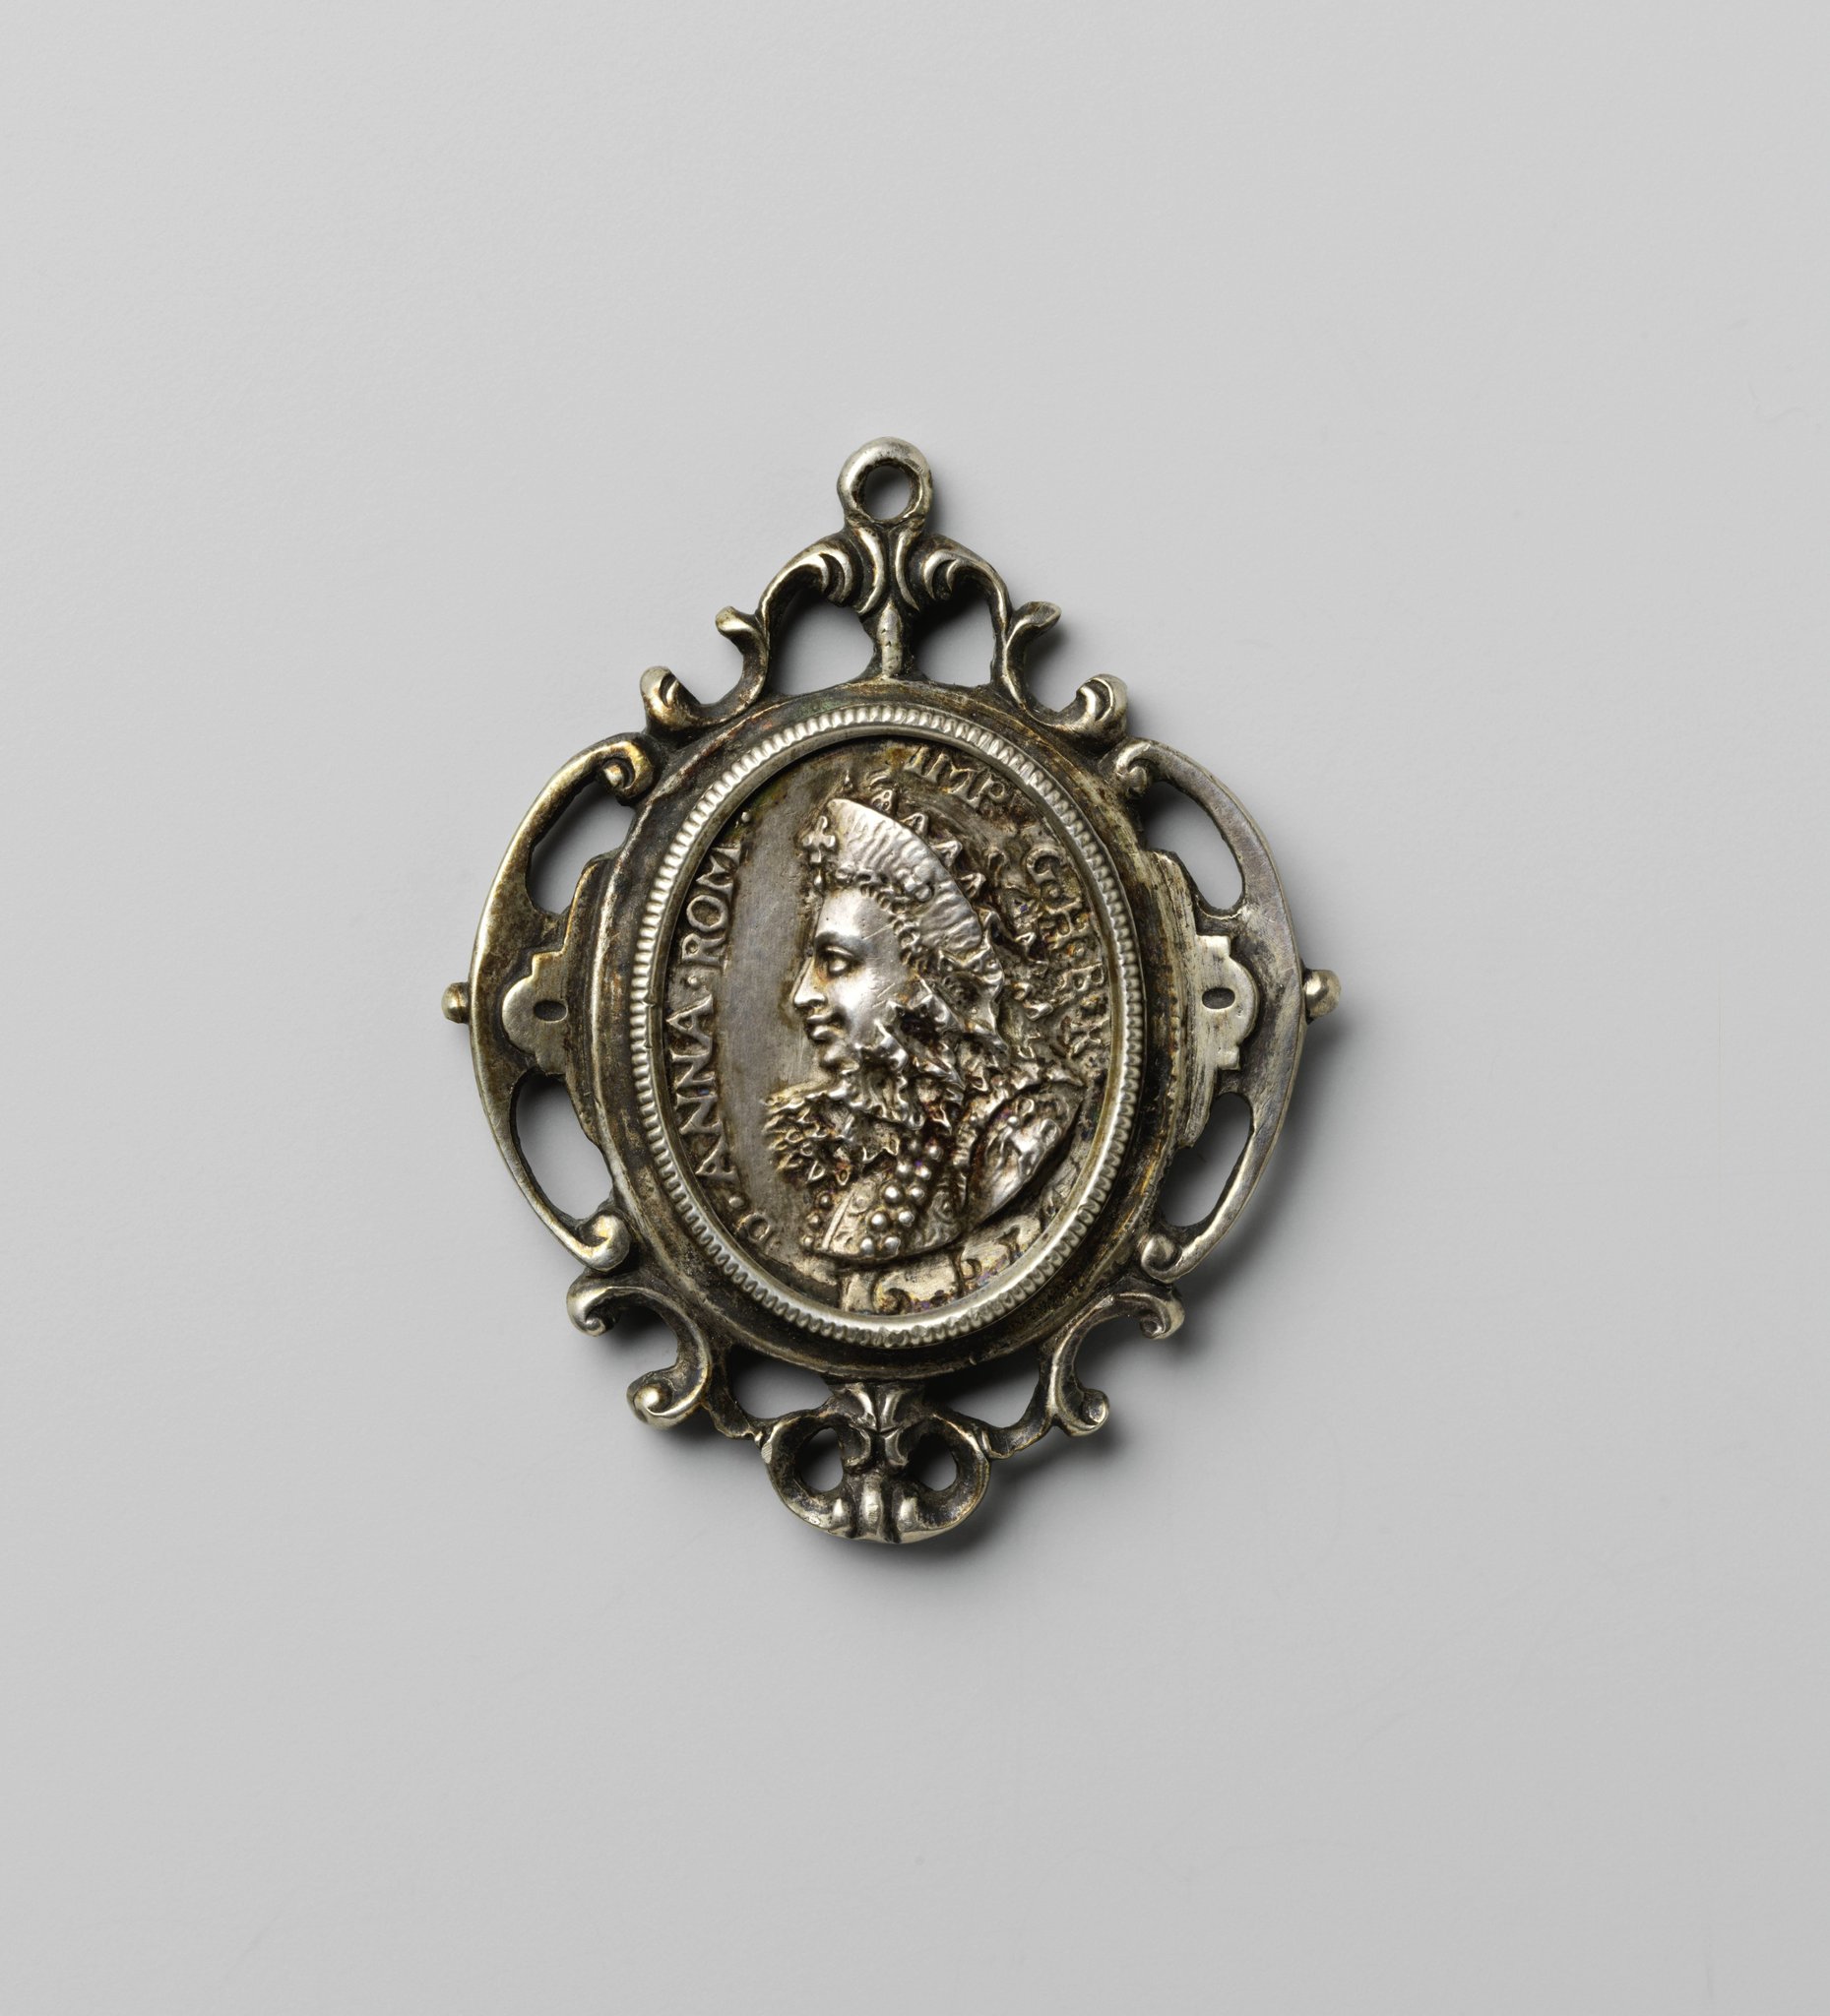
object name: pendant jewelry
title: Hanger in de vorm van een ovale penning met portret van Anna van Tirol, gemalin van keizer Matthias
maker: jan de vos (ca. 1578-?)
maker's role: silversmith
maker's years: 1578-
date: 1614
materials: silver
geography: southern germany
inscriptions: date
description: Hanger van zilver, gevormd uit een gemonteerde ovale penning met het portret van Anna, de gemalin van keizer Matthias.